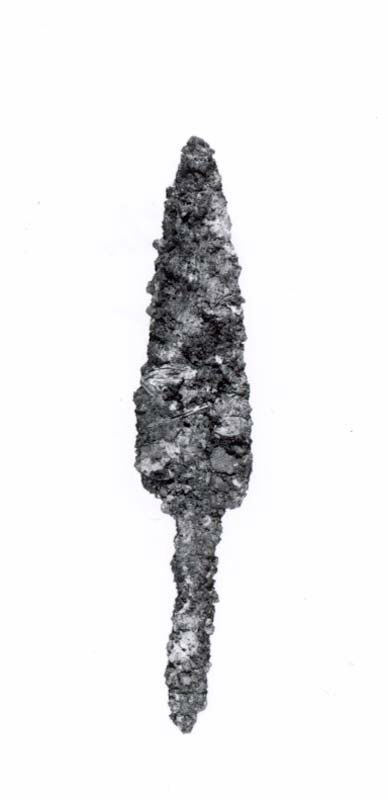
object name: arrowhead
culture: iranian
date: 900-801 BCE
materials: iron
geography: iran